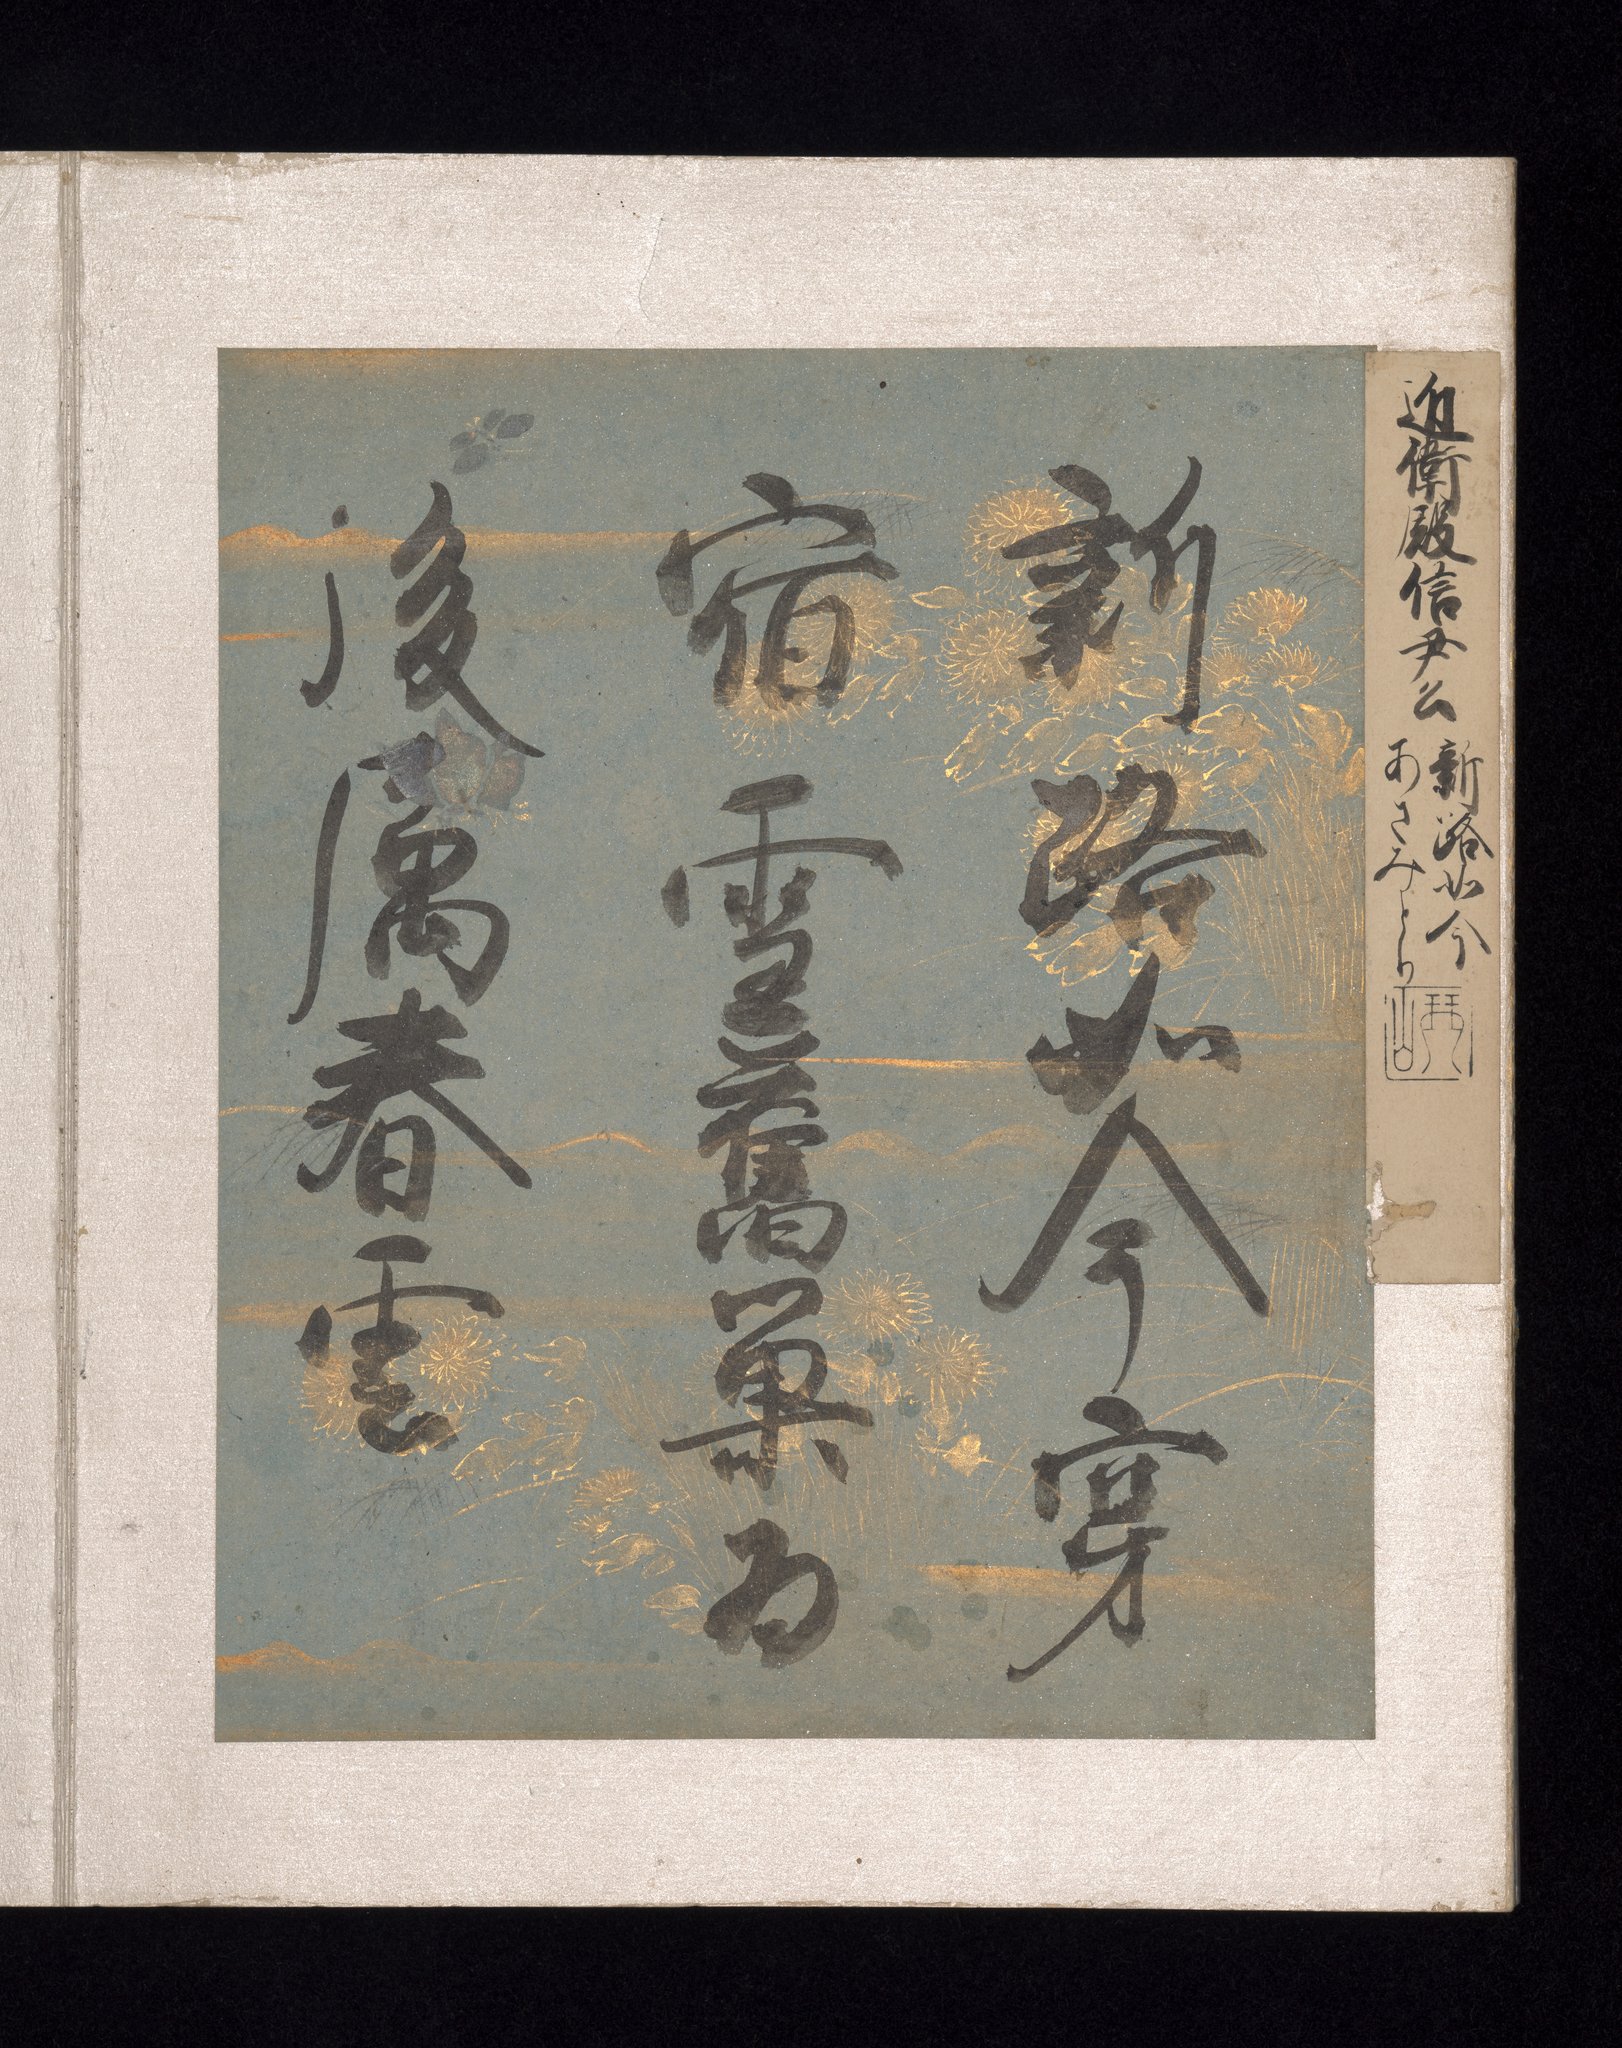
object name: album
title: Album of Japanese and Chinese Poems to Sing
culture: japanese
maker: konoe nobutada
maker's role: artist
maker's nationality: japanese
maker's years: 1565-1614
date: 1601-1633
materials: gold, paper, silver